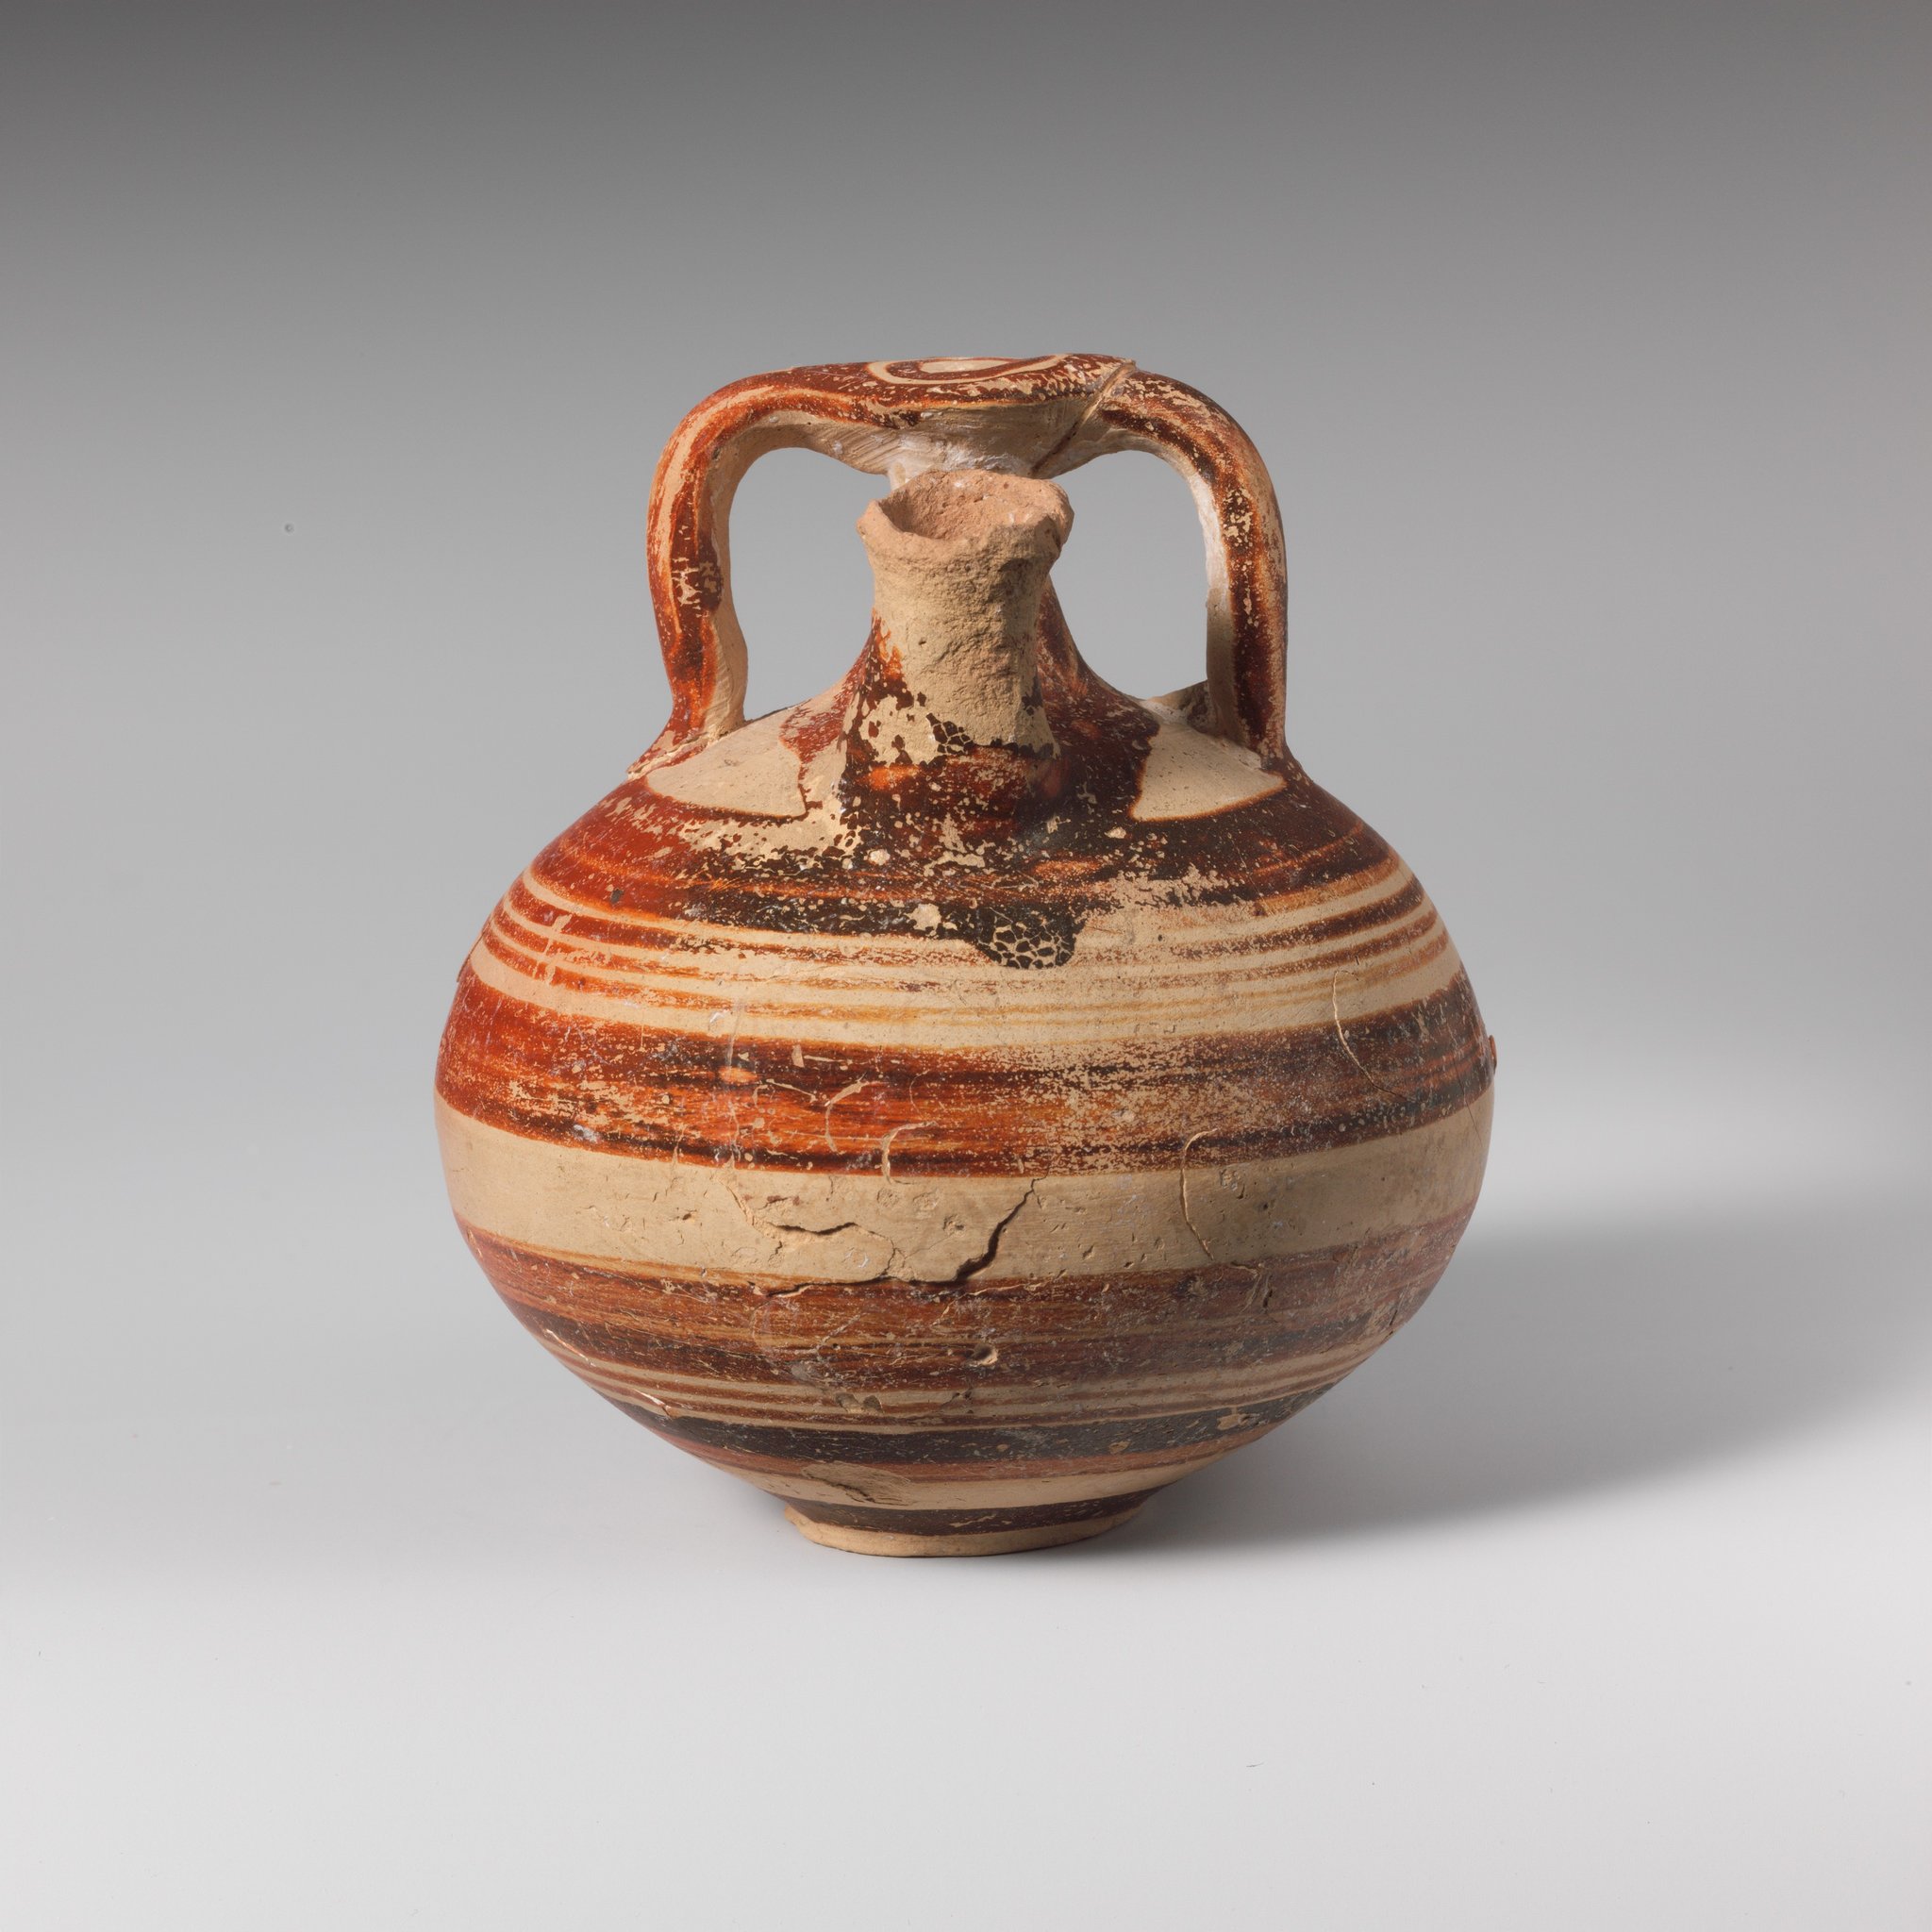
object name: stirrup jar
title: Terracotta stirrup jar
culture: mycenaean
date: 1325-1200 BCE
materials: terracotta